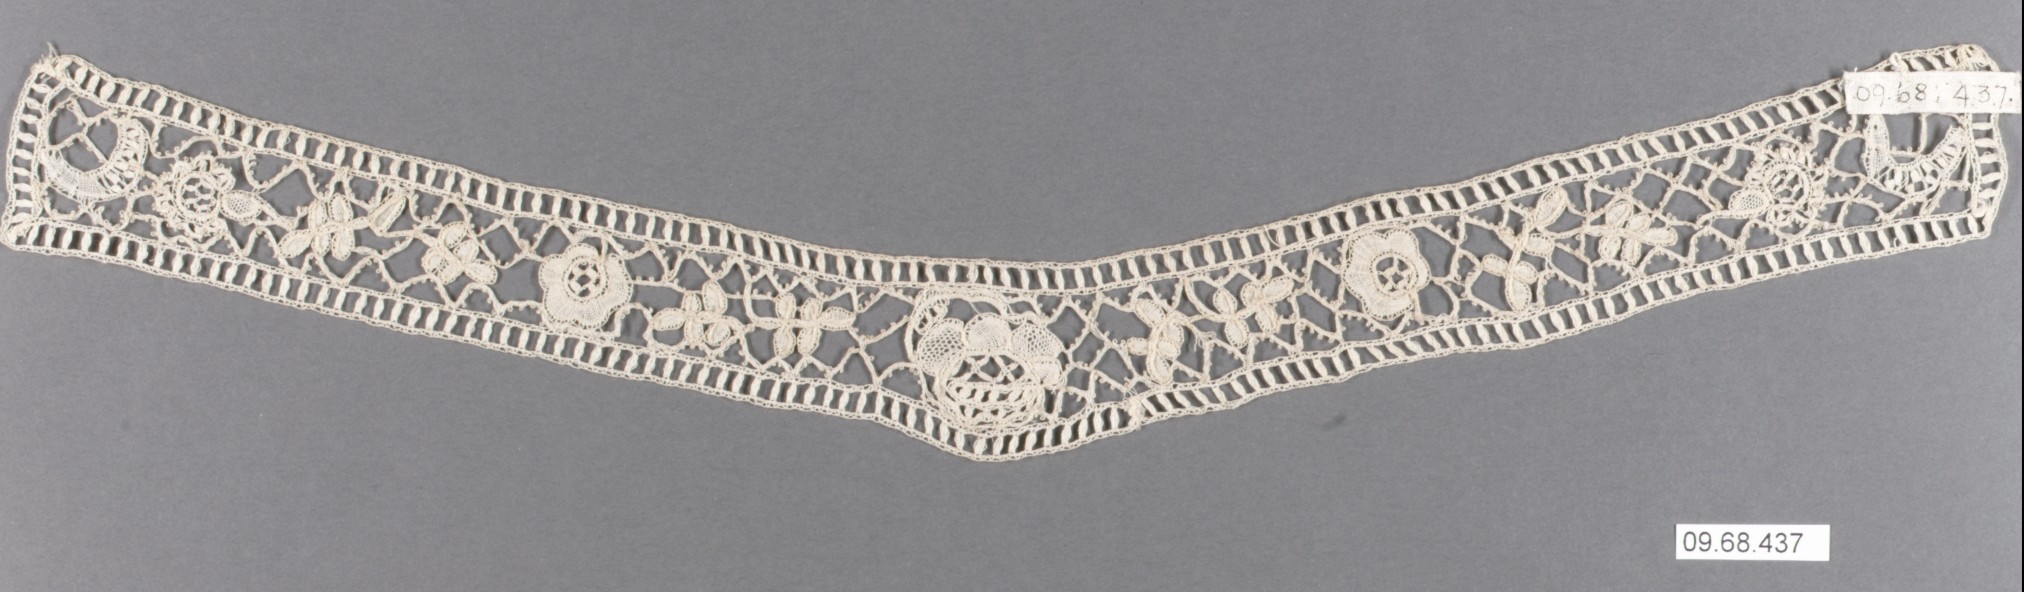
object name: neckband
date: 1801-1900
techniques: lace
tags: flowers